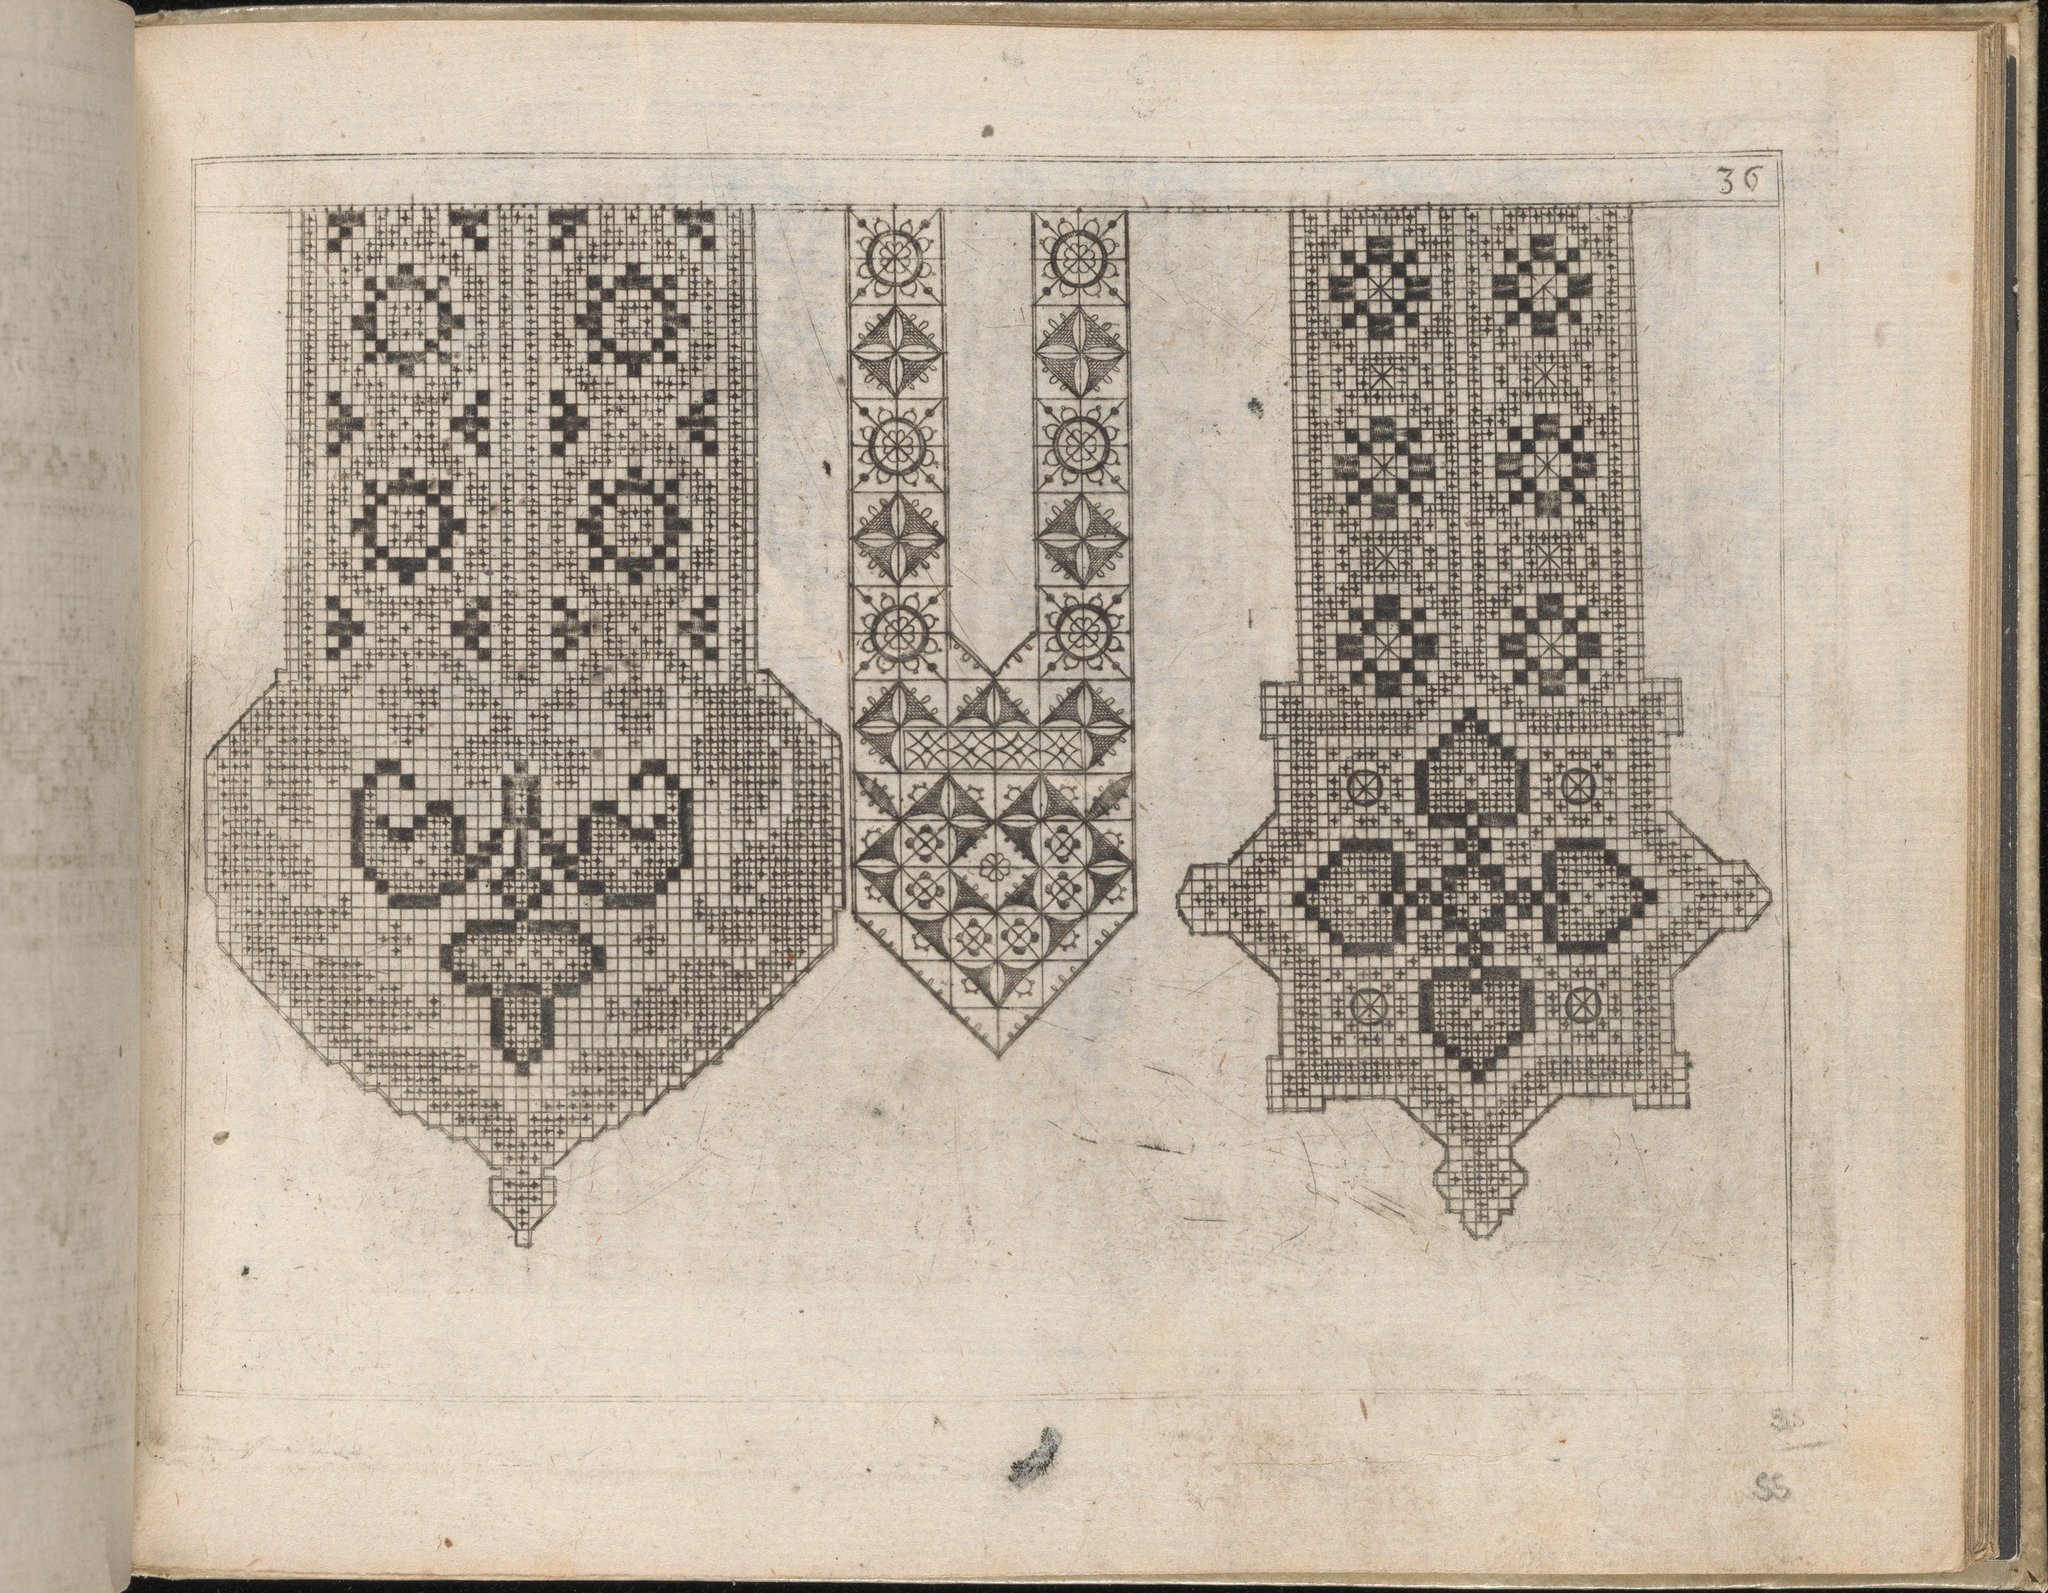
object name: book print ornament architecture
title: Newes Modelbuch in Kupffer (Page 44r)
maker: johann sibmacher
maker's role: artist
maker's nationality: german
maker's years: 1590-1611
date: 1604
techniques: etching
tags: ornament